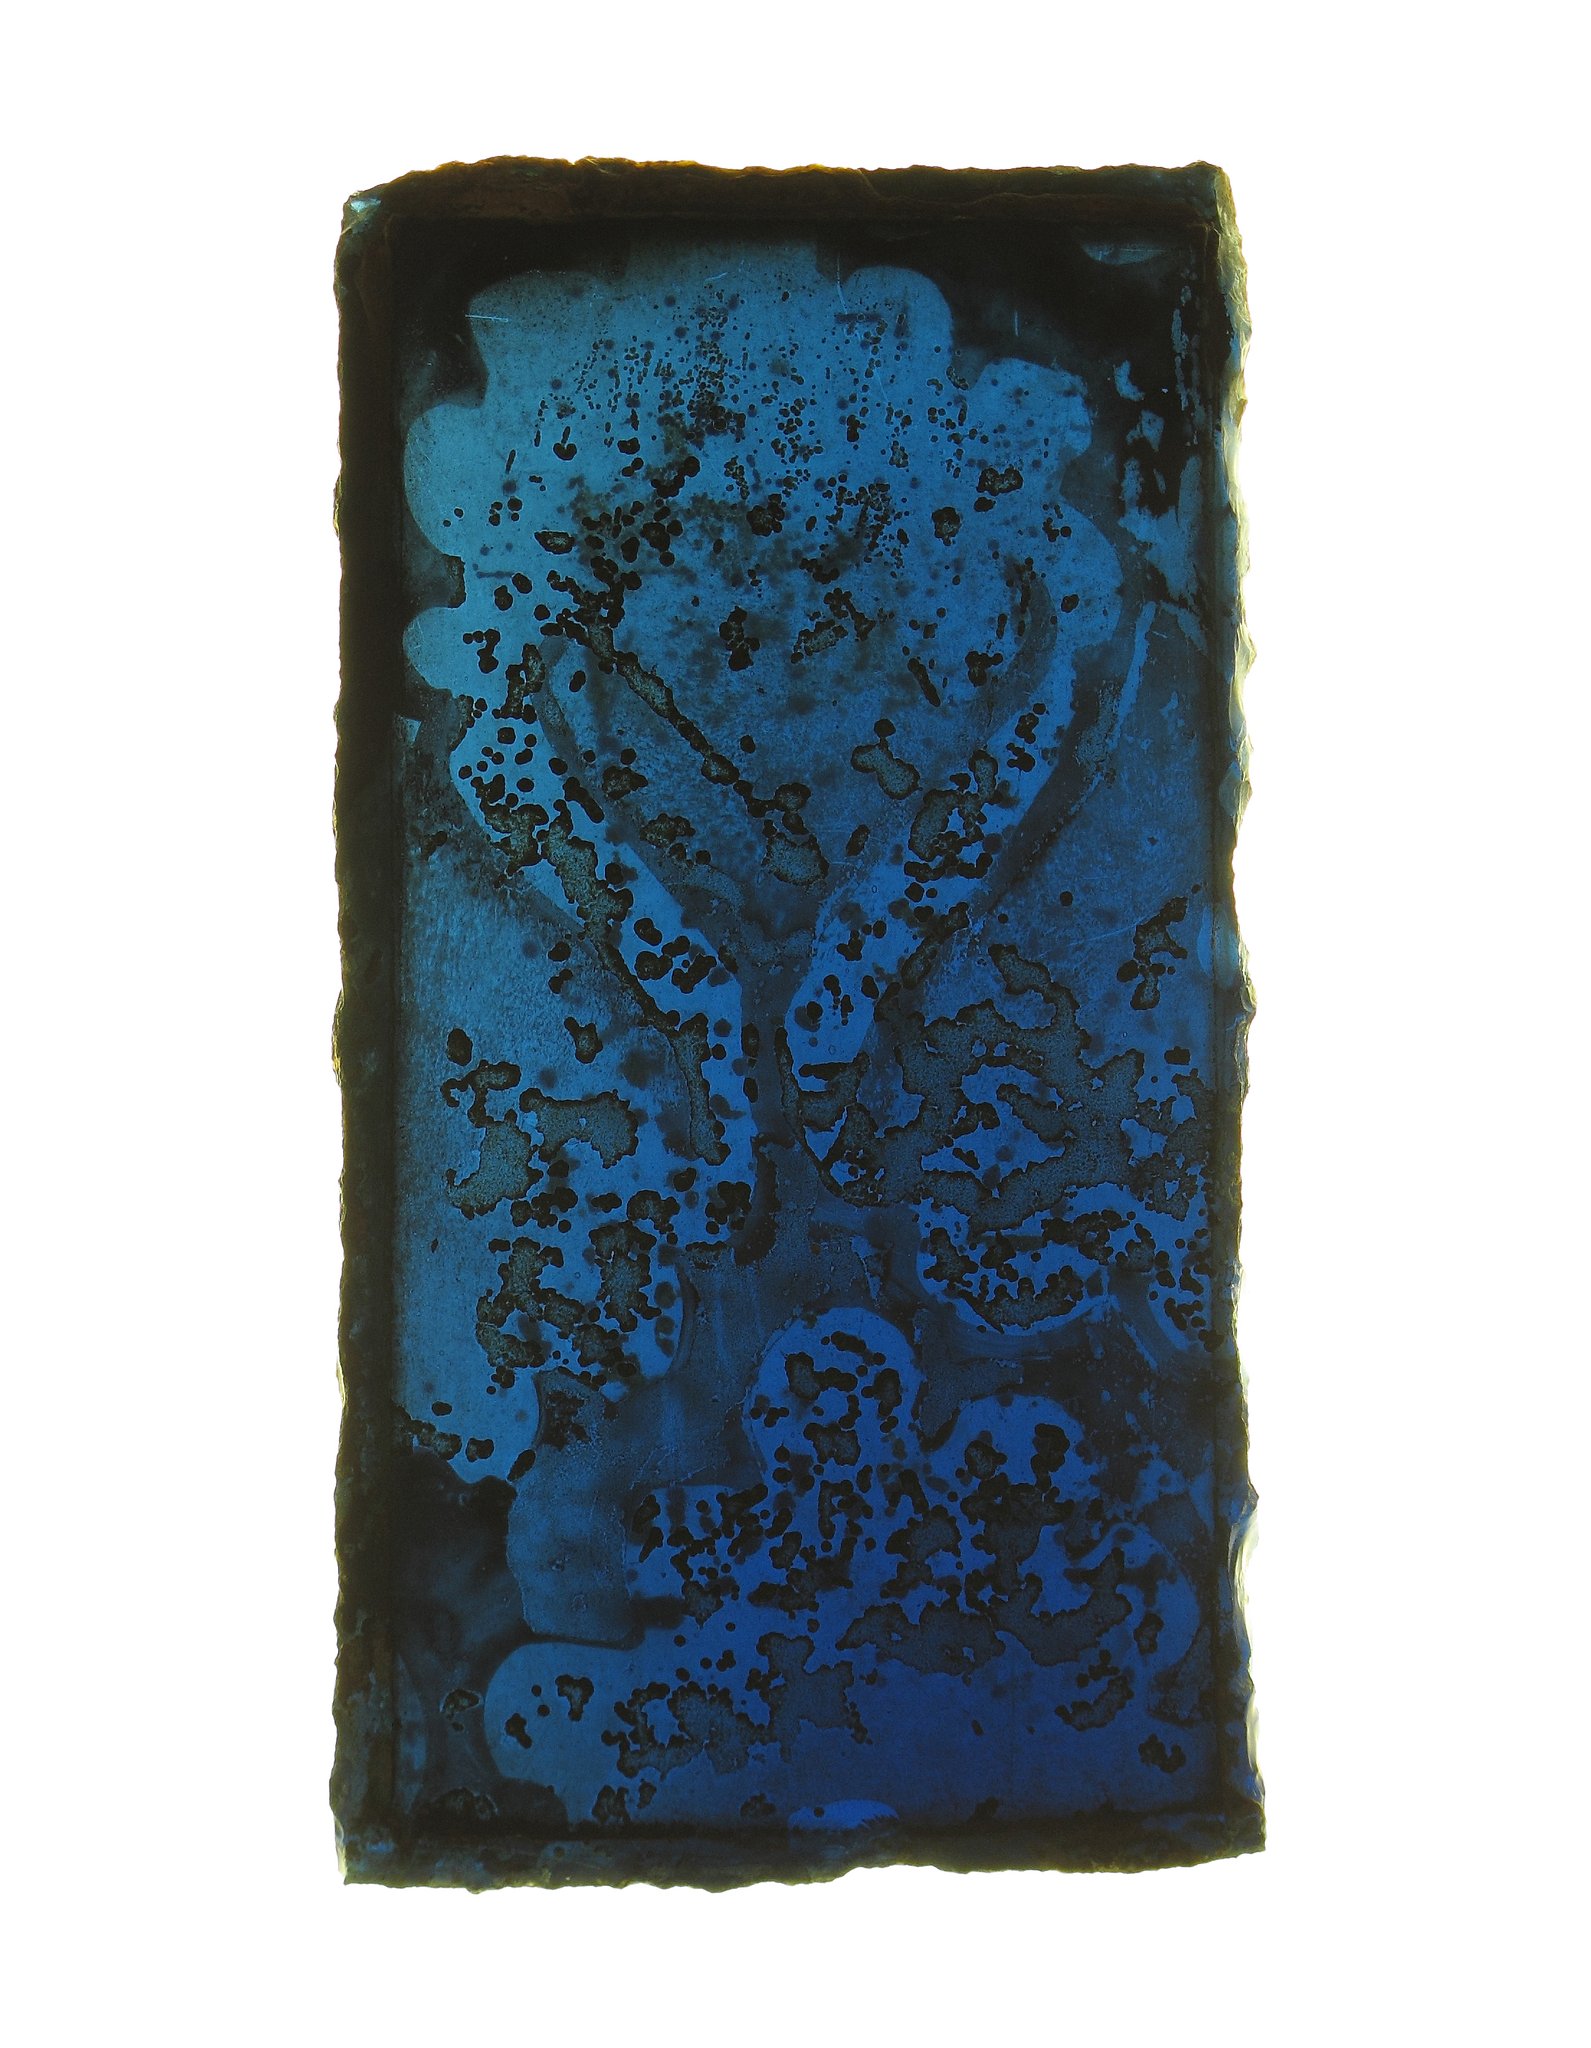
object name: fragment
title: Glass Fragment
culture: french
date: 1401-1500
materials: glass, metal